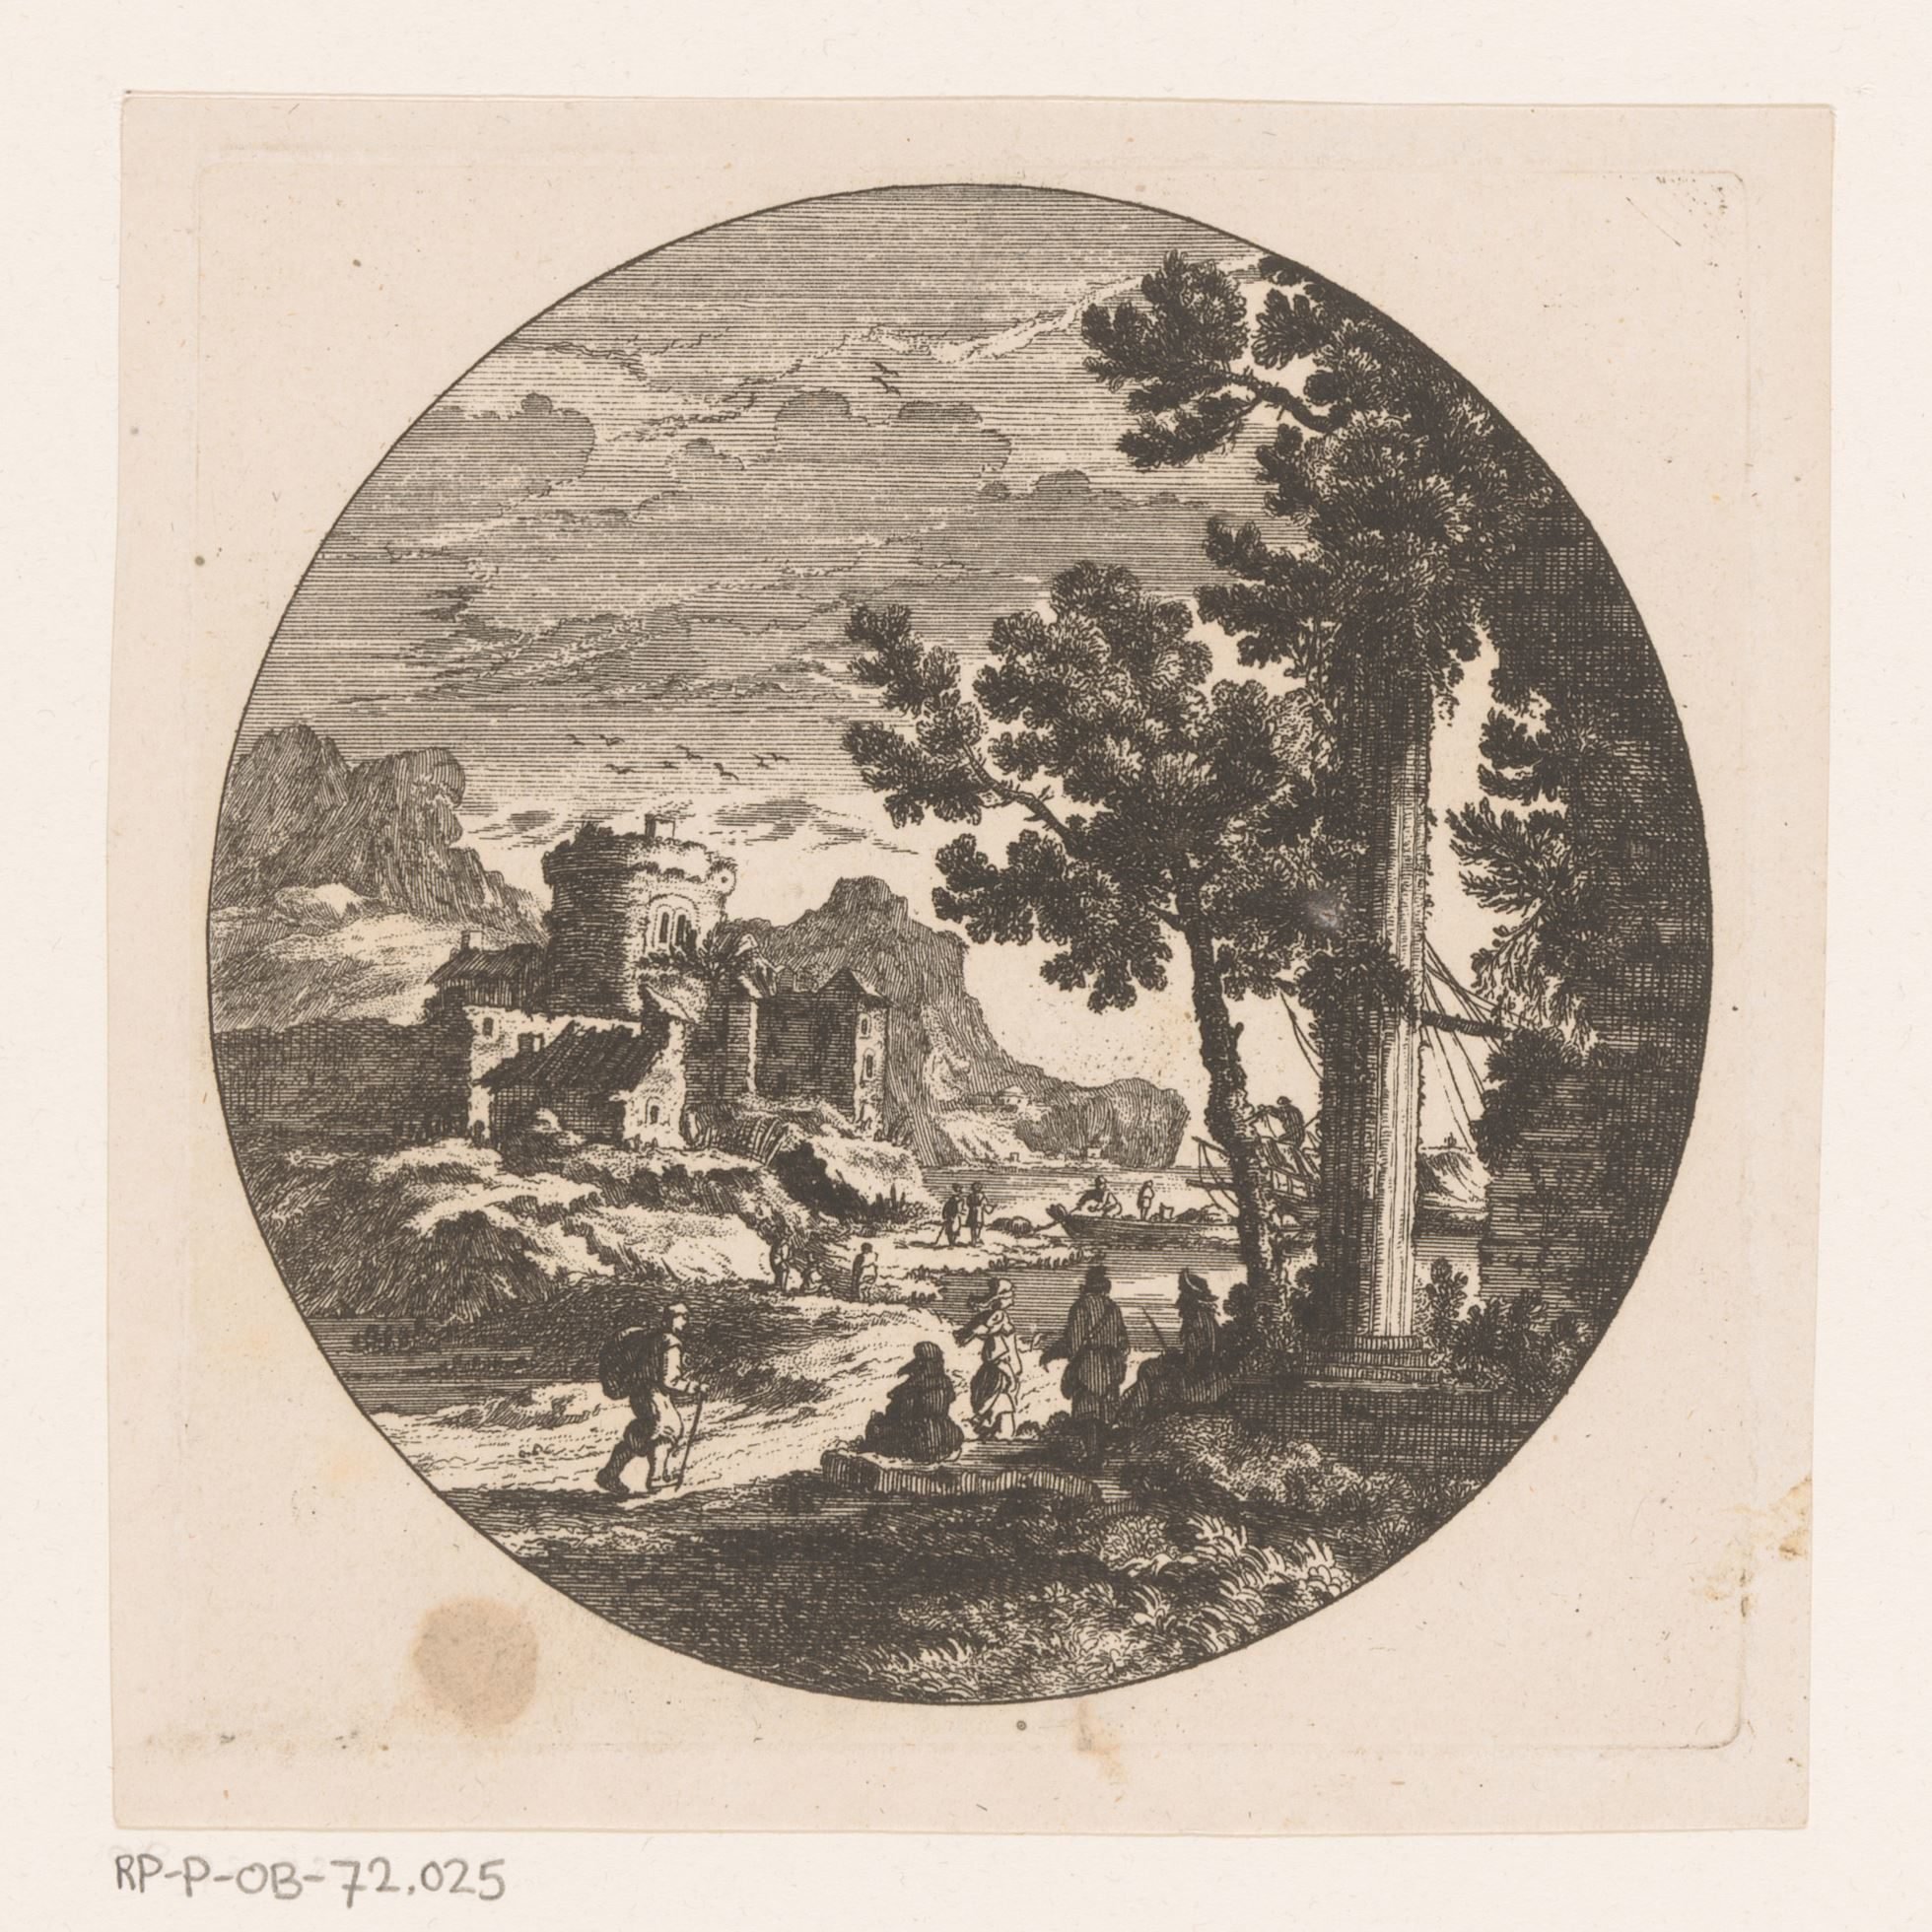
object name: print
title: Kustlandschap met zuil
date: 1613-1695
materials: paper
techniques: etching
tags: coast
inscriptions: collector's mark: Lugt 2228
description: Prenten met het signatuur 'Perelle' kunnen zowel door vader Gabriel als door zonen Nicolas en Adam gemaakt zijn.